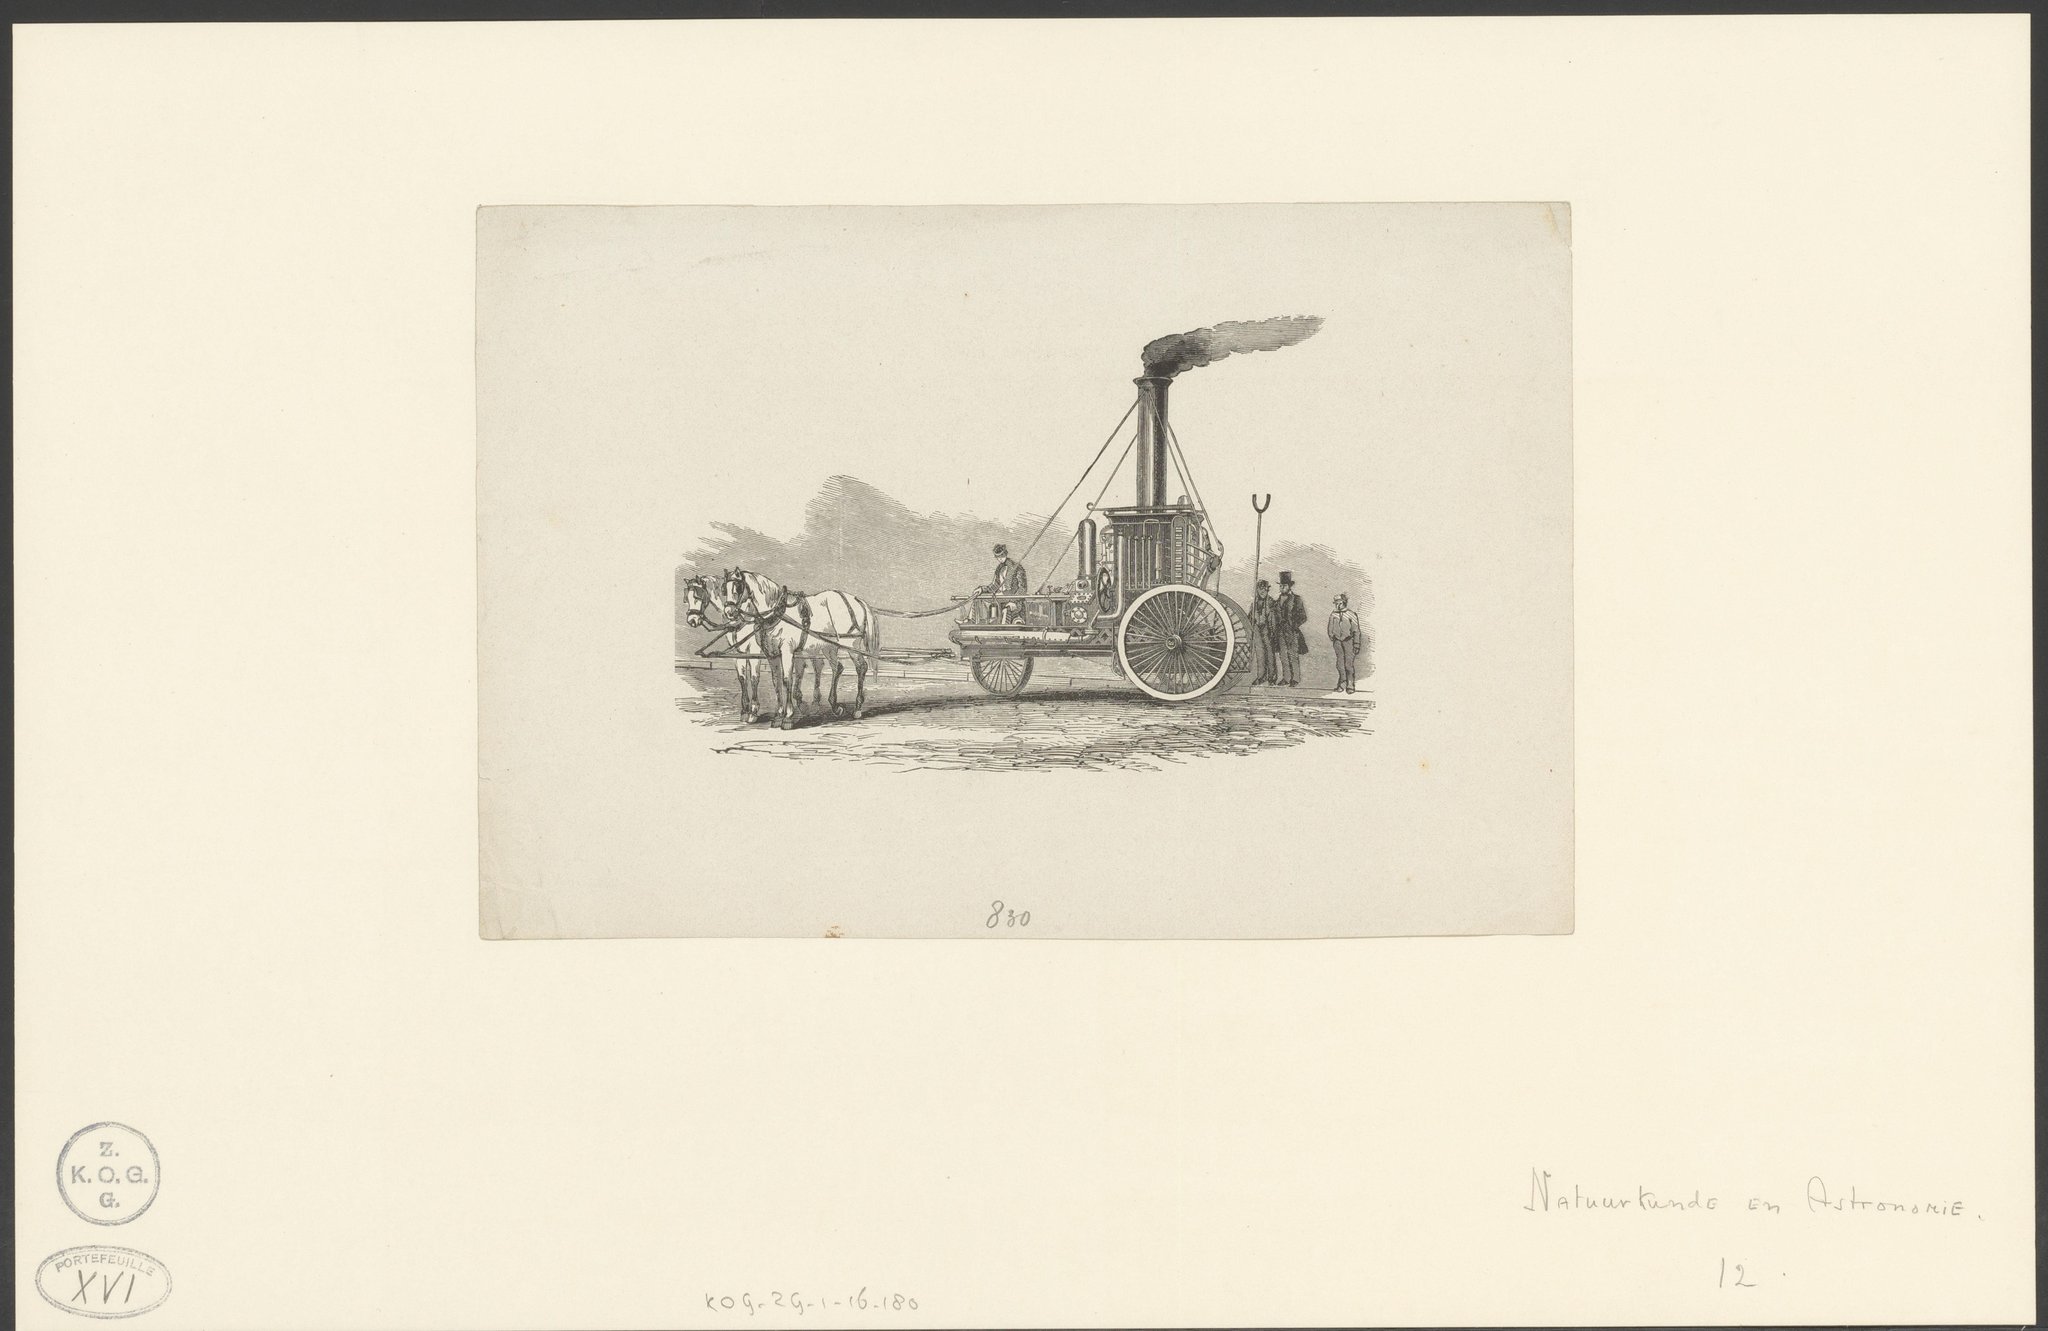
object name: print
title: Stoommachine getrokken door twee paarden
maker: Anonymous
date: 1800-1899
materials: paper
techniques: engraving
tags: machine driven by steam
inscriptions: stamp, collector's mark: Lugt 1641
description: Onderwerpsrubrieken binnen de Atlas Zeden en Gewoonten: Onderwijs en Wetenschappen, Astrologen (Natuurkunde en Astronomie).